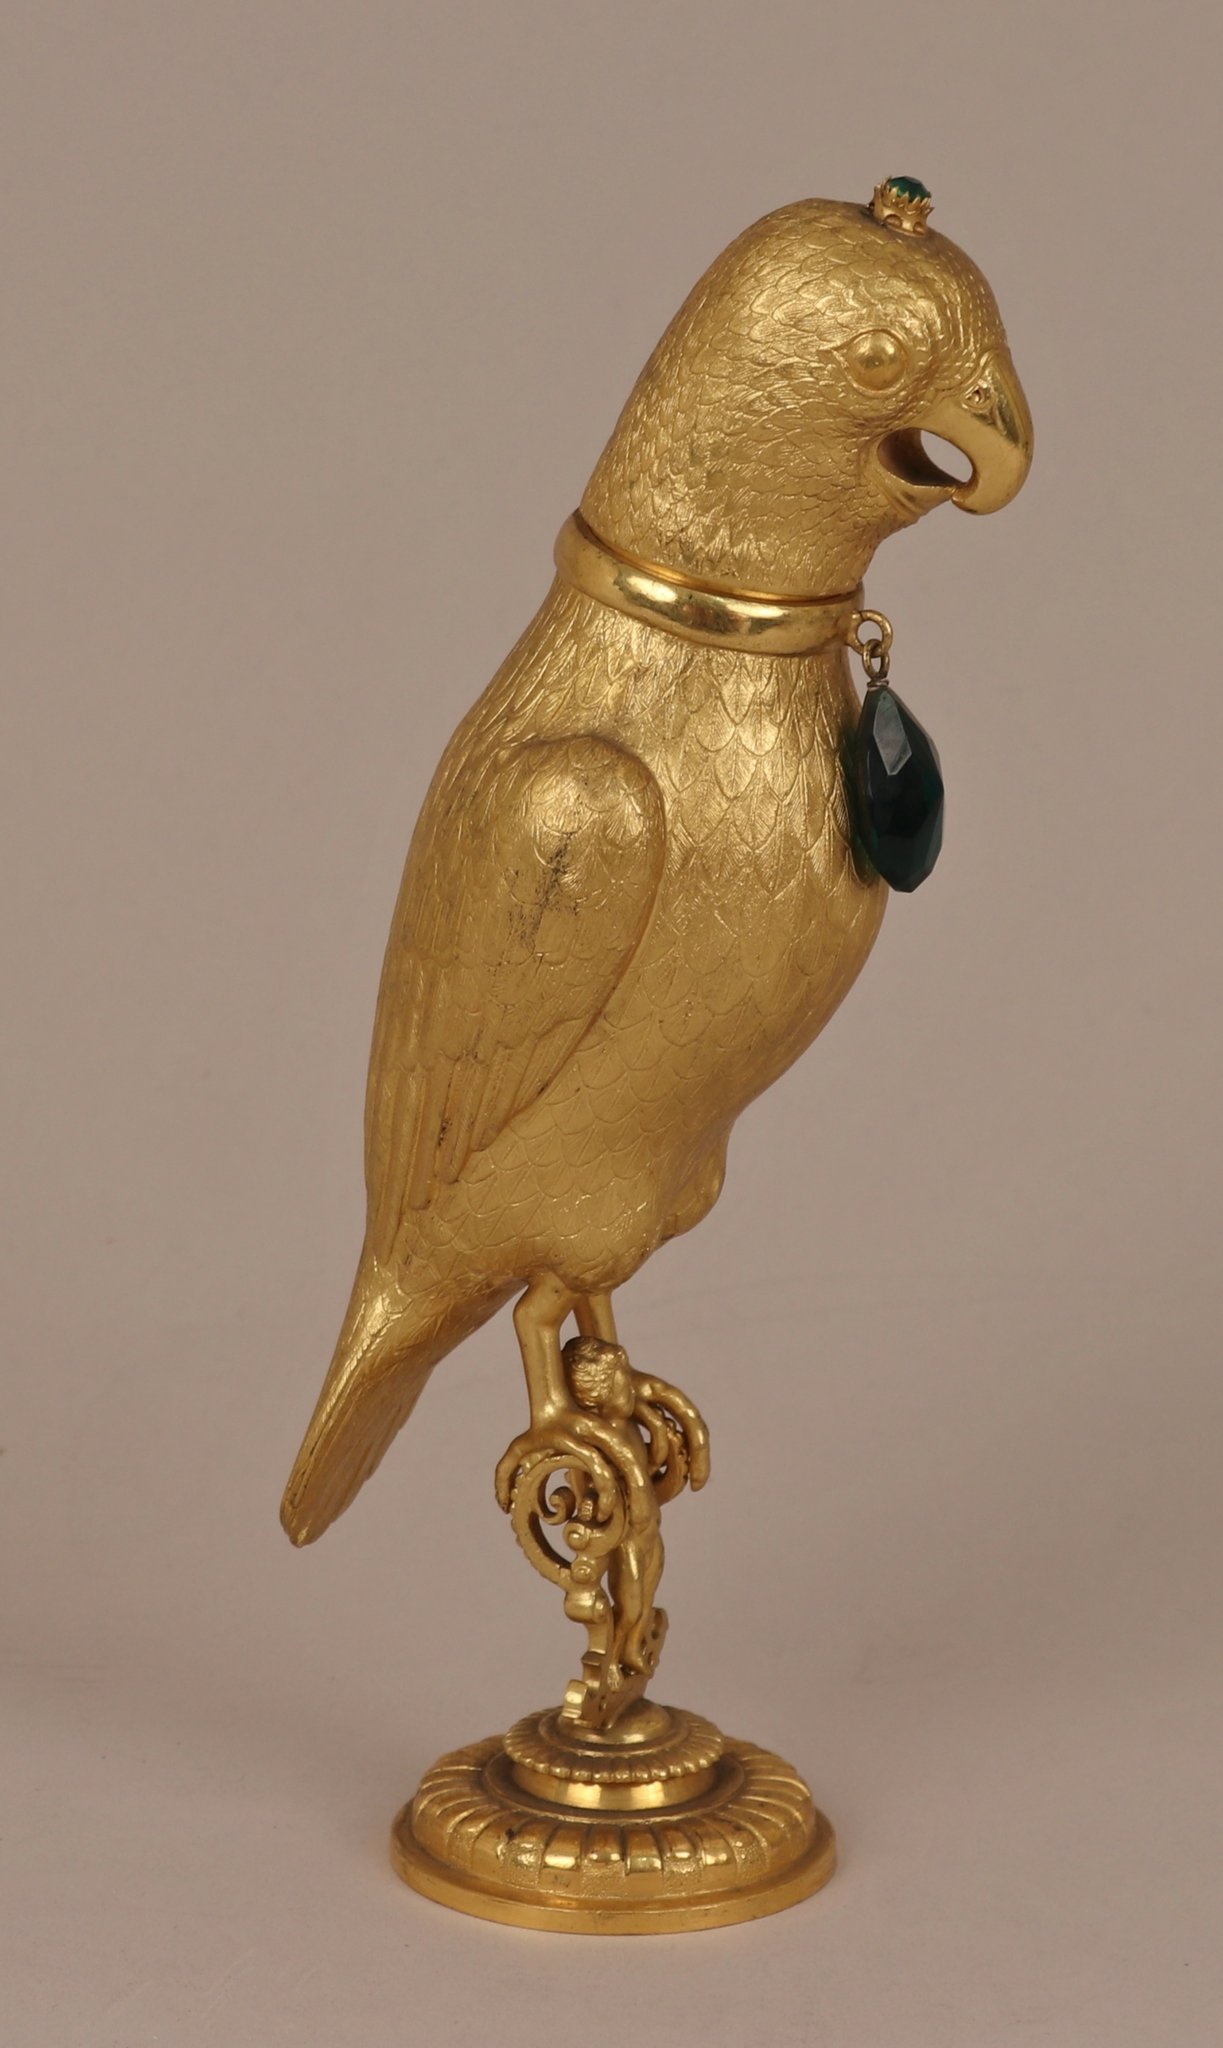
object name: cup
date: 1801-1900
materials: silver gilt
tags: parrots